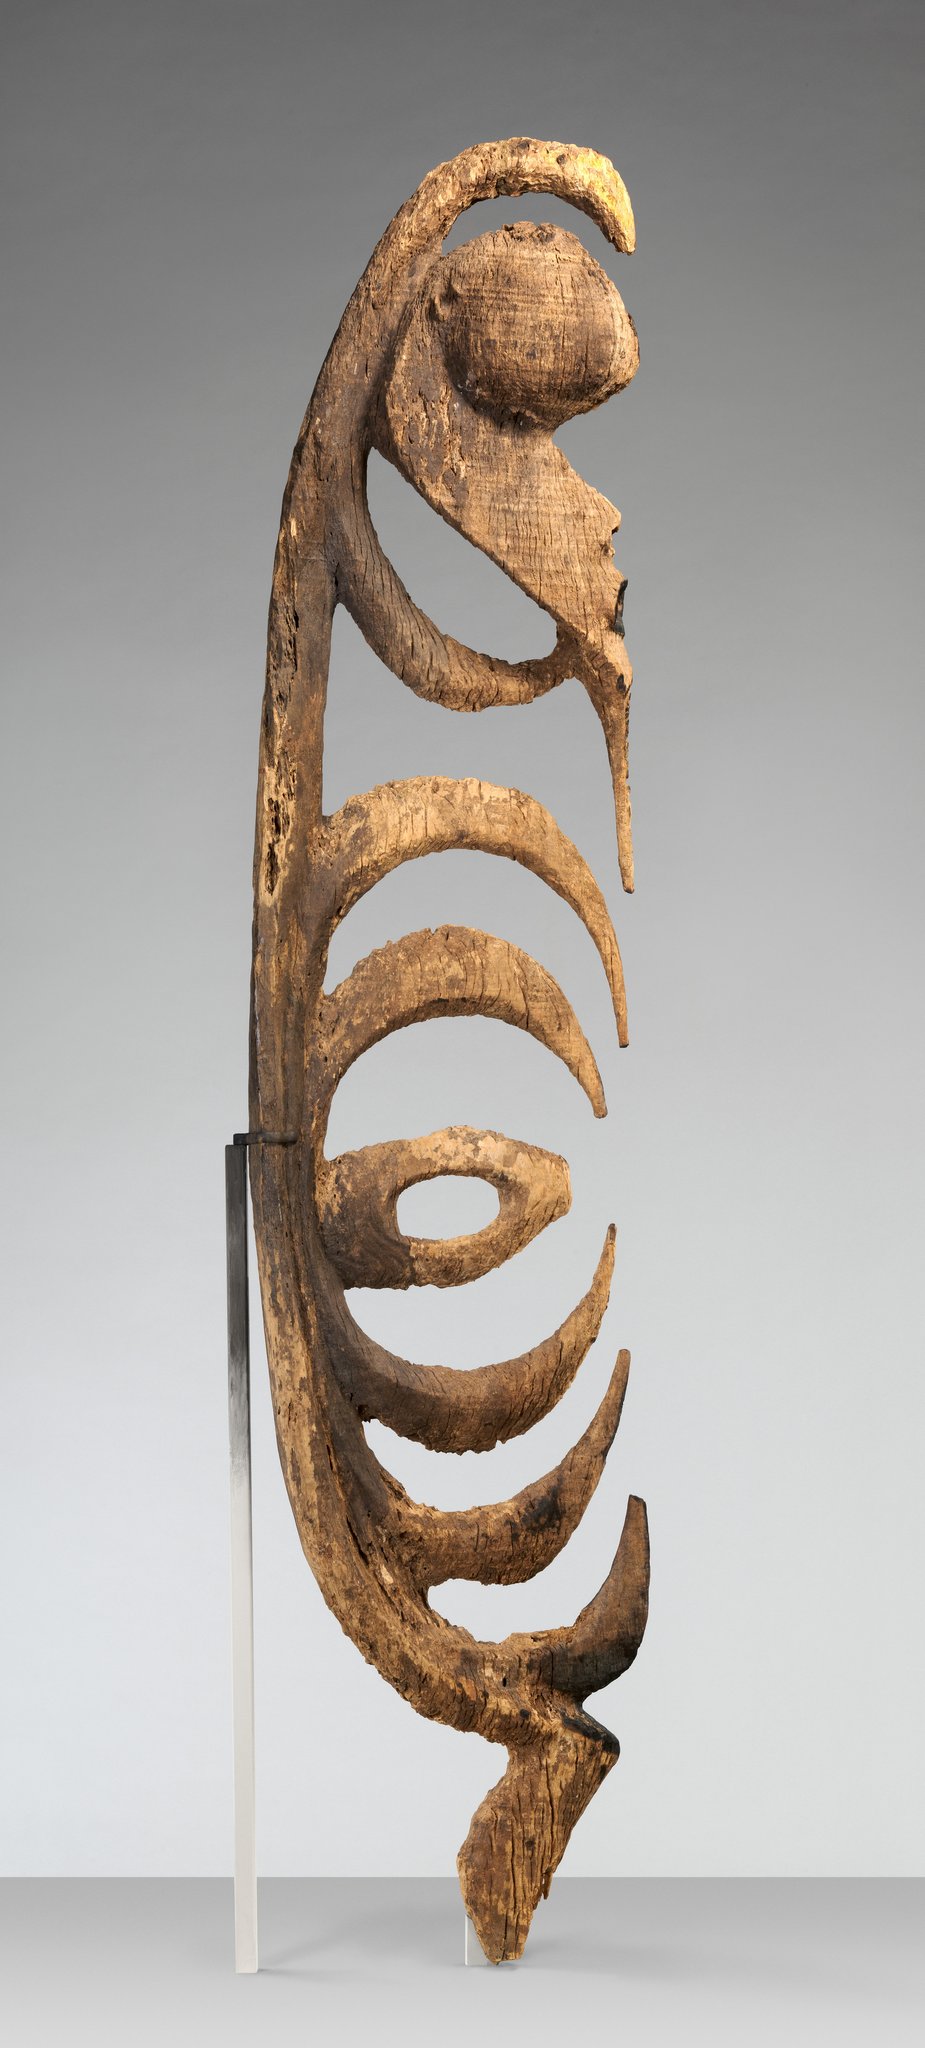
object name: figure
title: Figure (Yipwon)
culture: yimam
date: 1801-1900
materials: wood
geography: papua new guinea